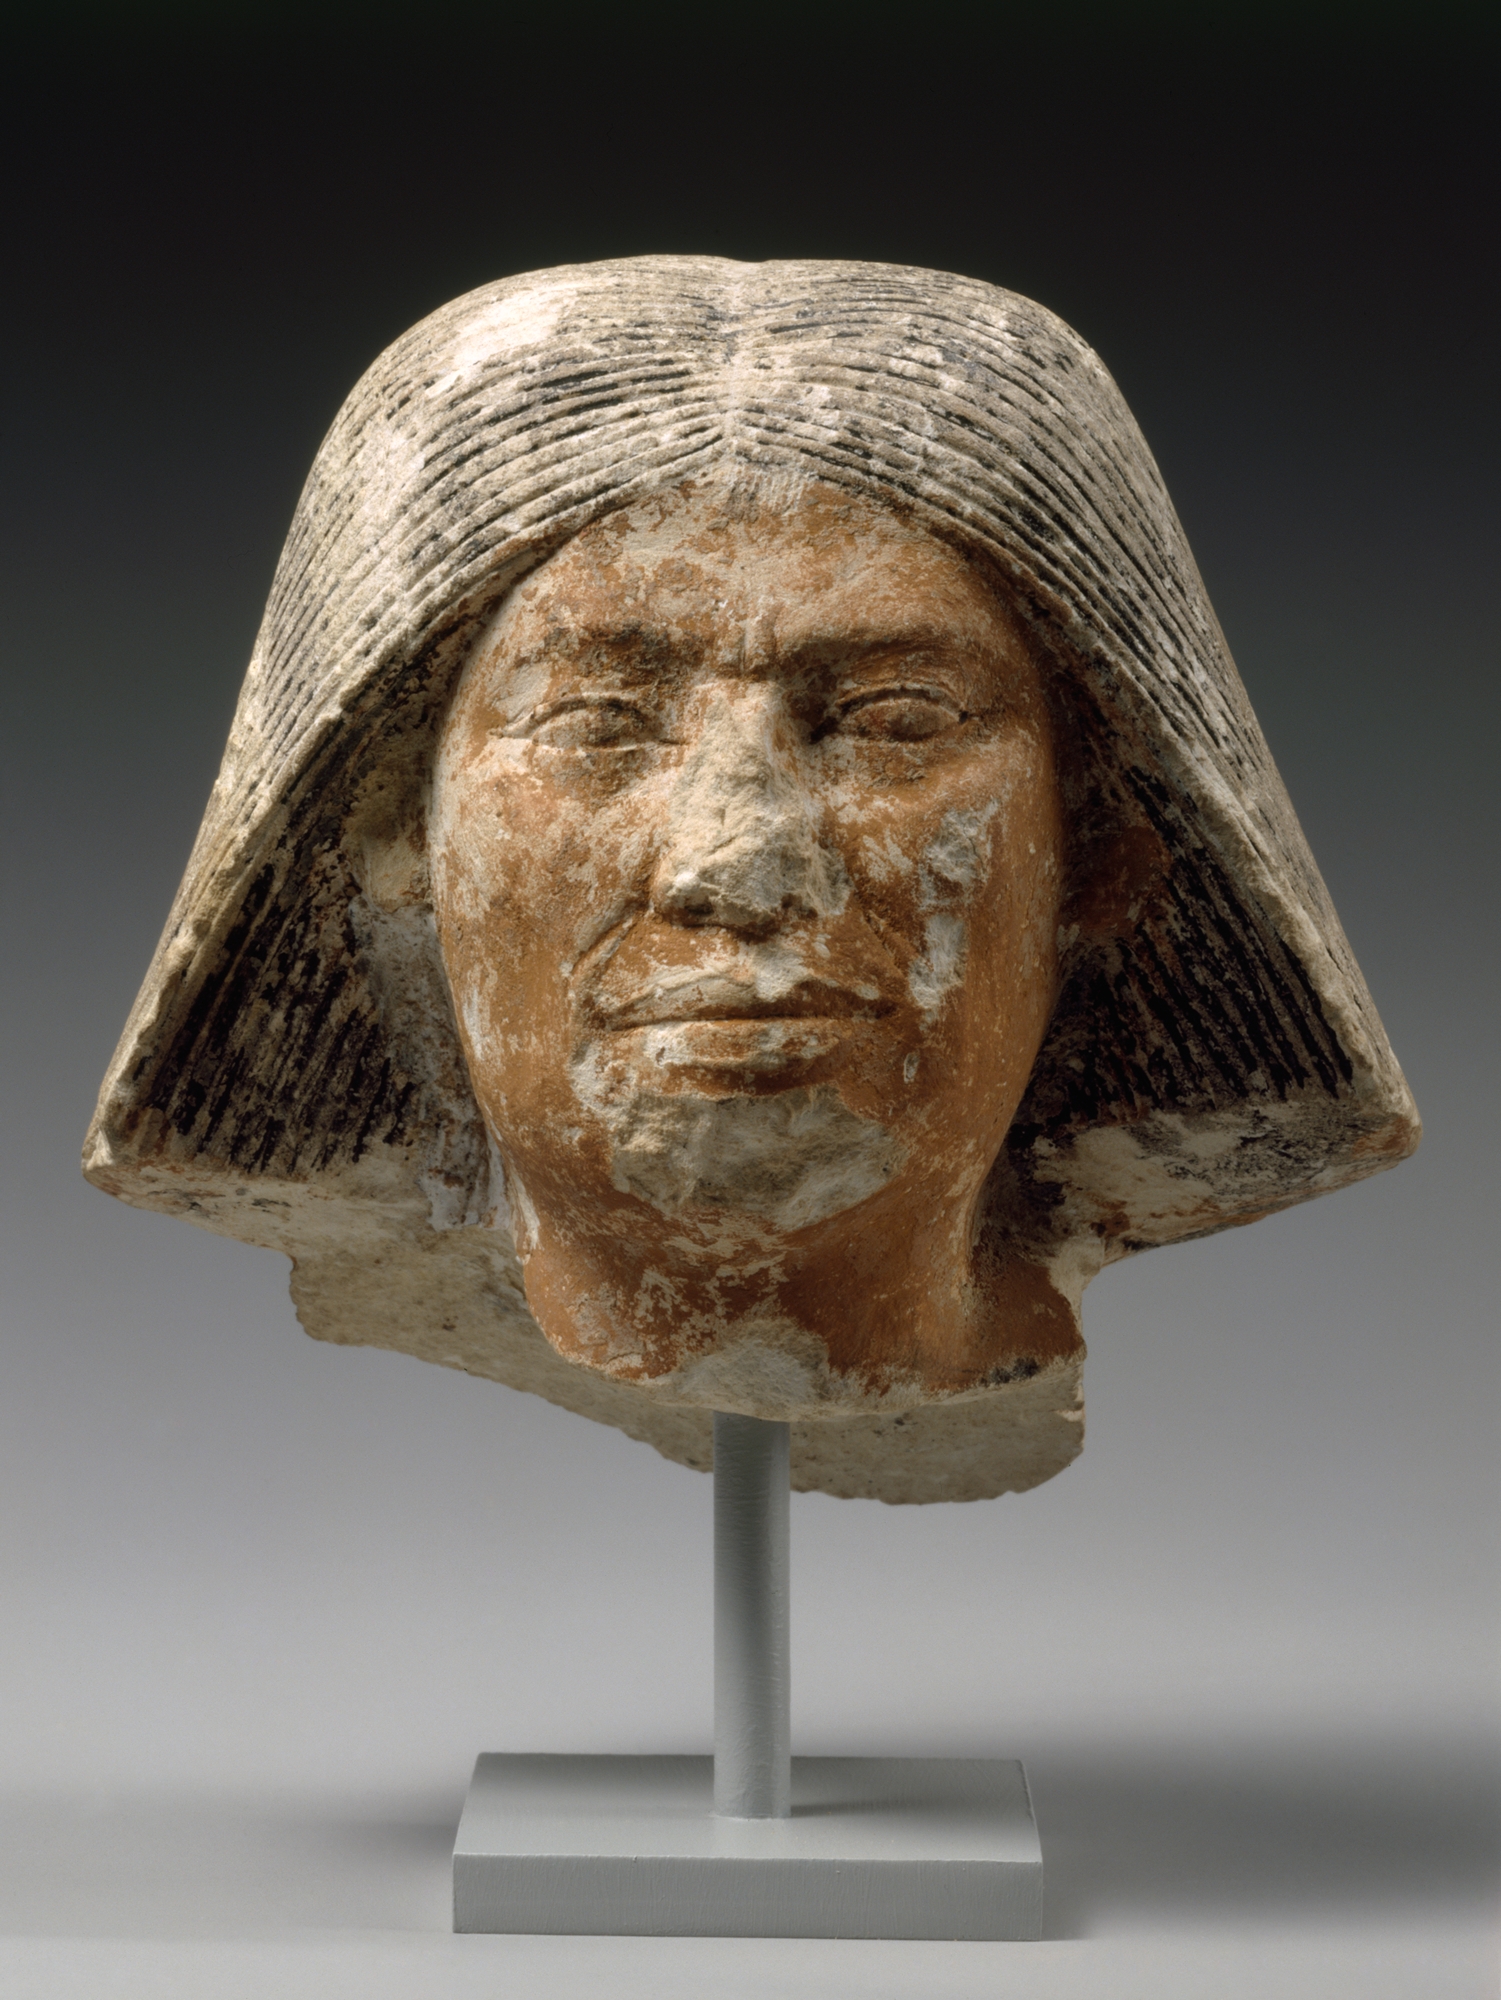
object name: head, male statue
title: Head of a statue of an older man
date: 2550-2460 BCE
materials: limestone, paint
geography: egypt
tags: heads,men